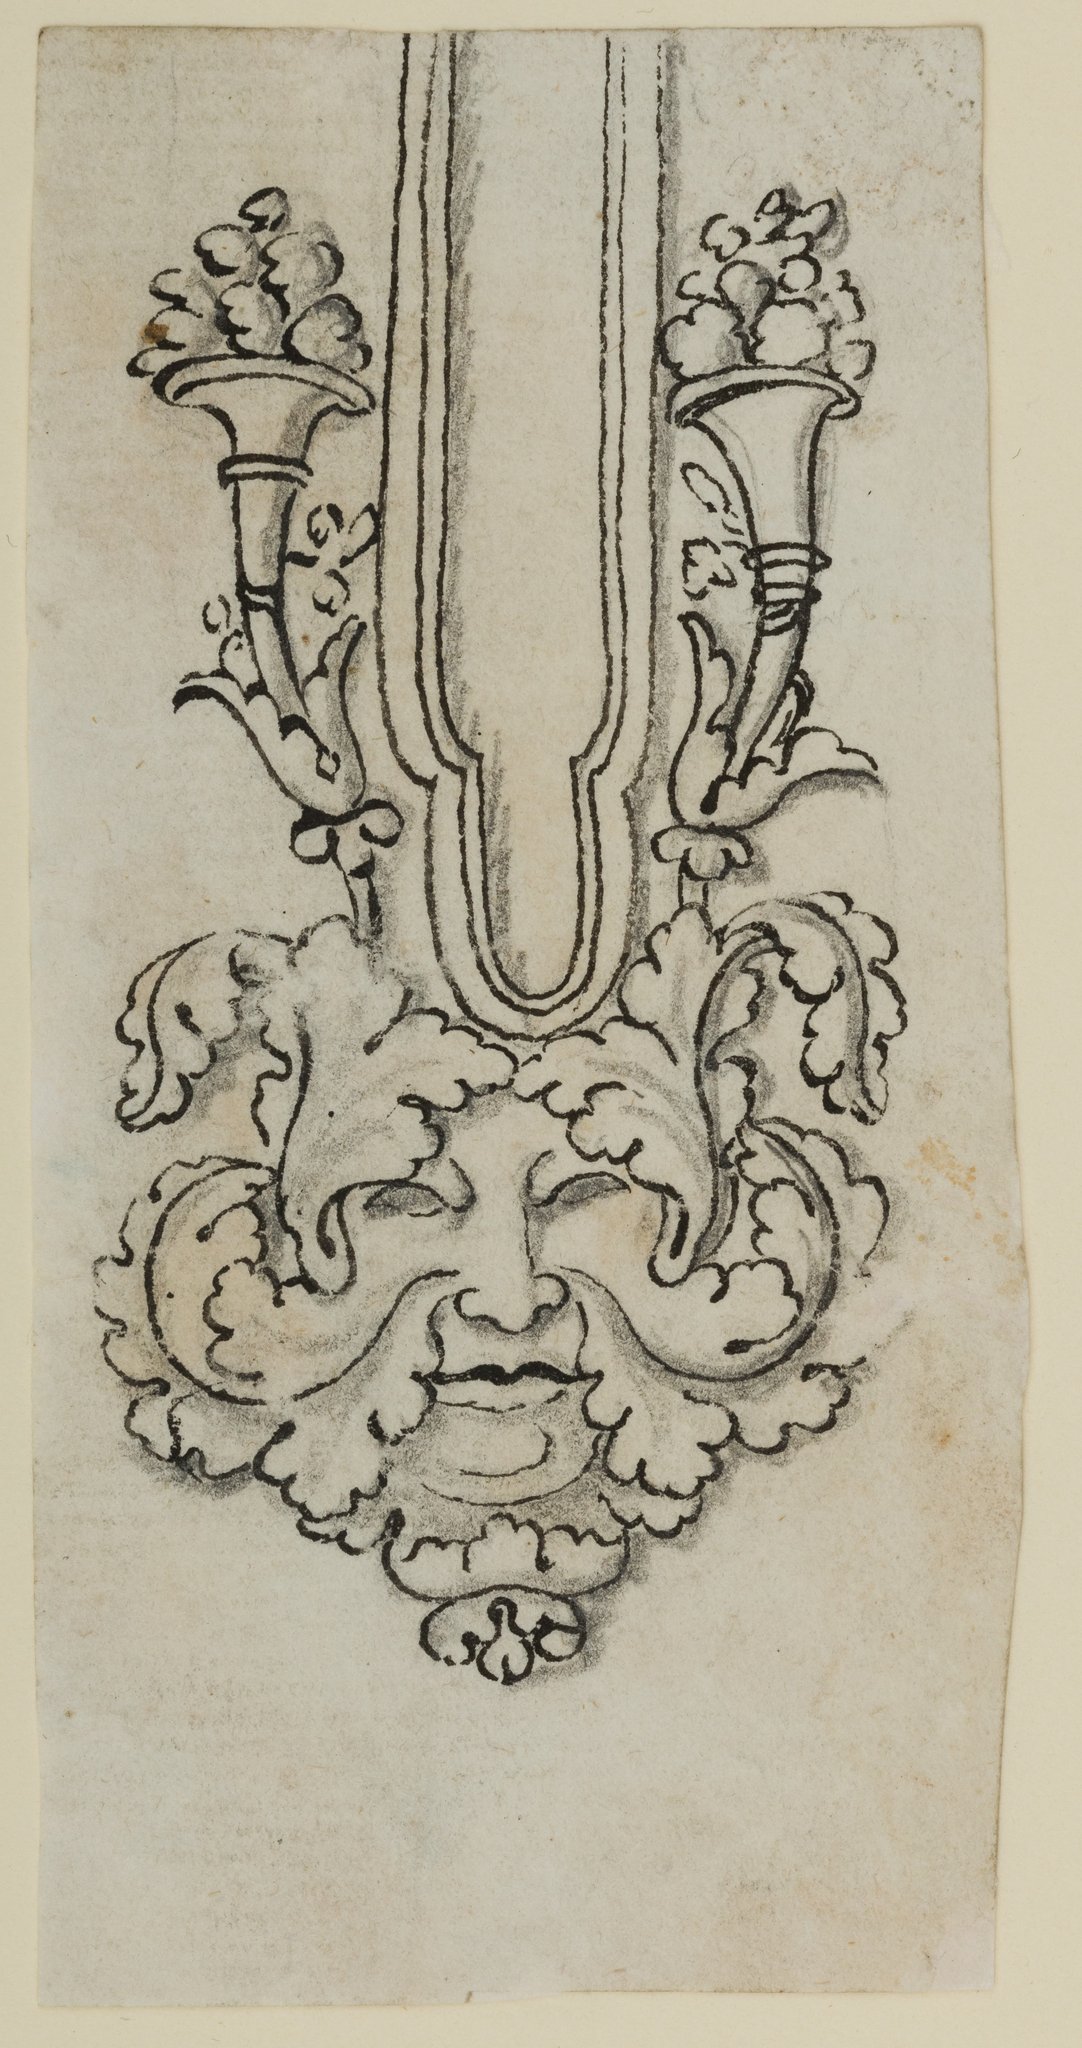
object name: drawing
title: Design for the Decoration of the Barrel Tang Surround of a Firearm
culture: french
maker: nicolas noël boutet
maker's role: designer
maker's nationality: french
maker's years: 1761-1833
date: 1797-1805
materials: ink, paper, pencil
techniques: wash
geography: france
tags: ornament